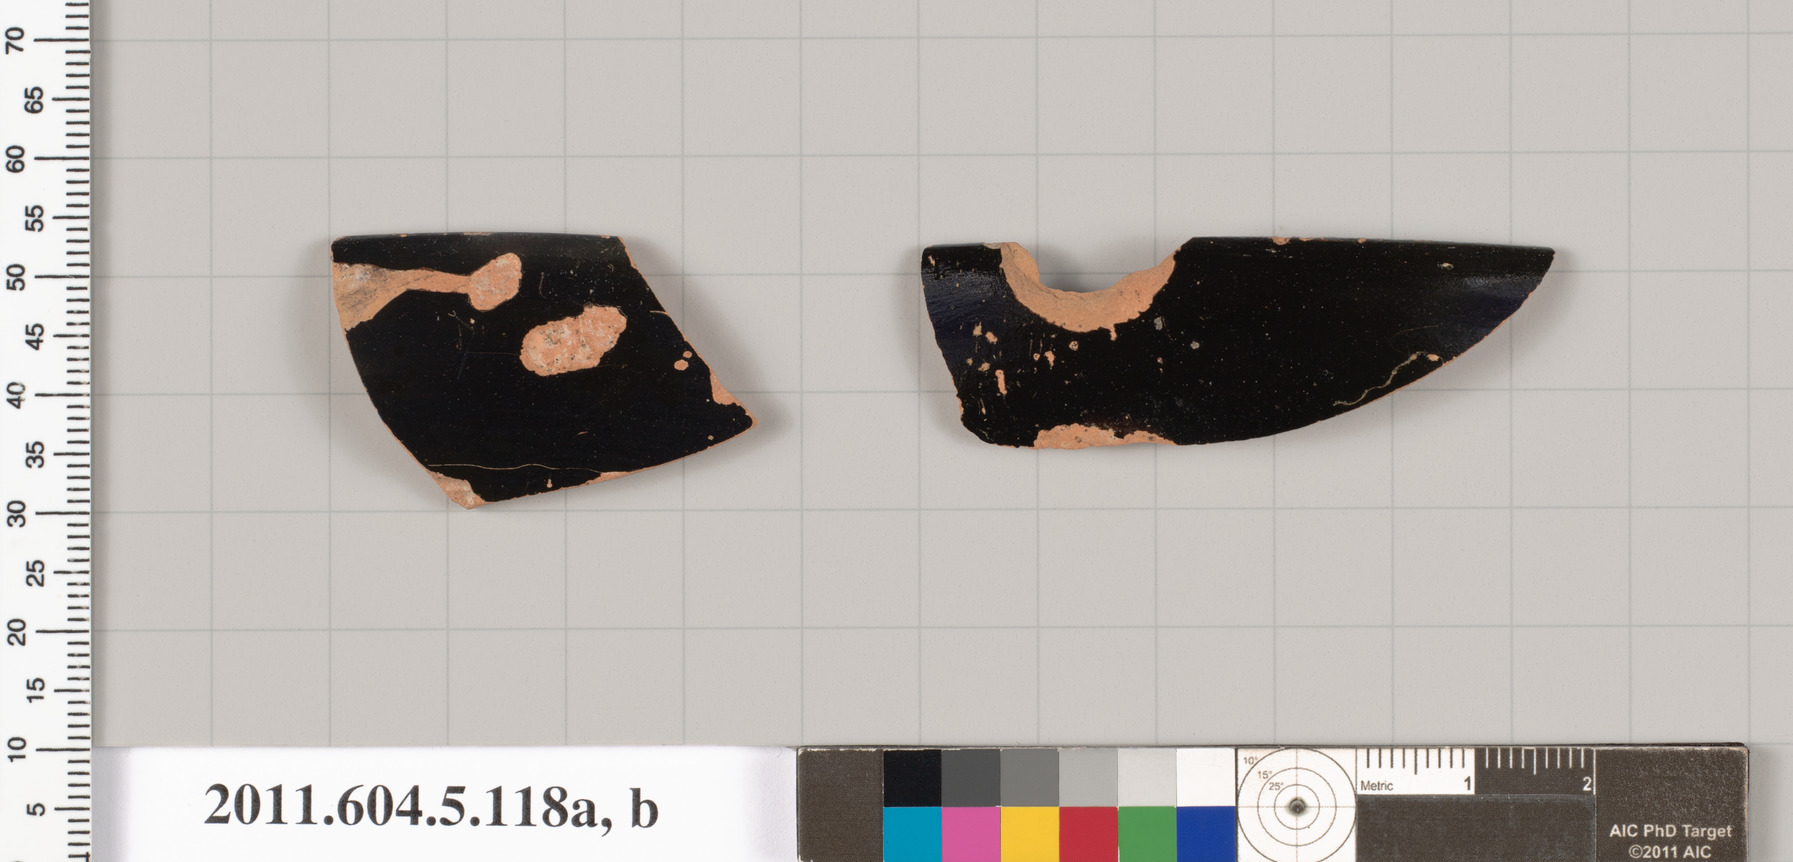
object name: kylix fragment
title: Terracotta rim fragments of stemless kylikes (drinking cups)?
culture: greek, attic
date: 470-450 BCE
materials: terracotta